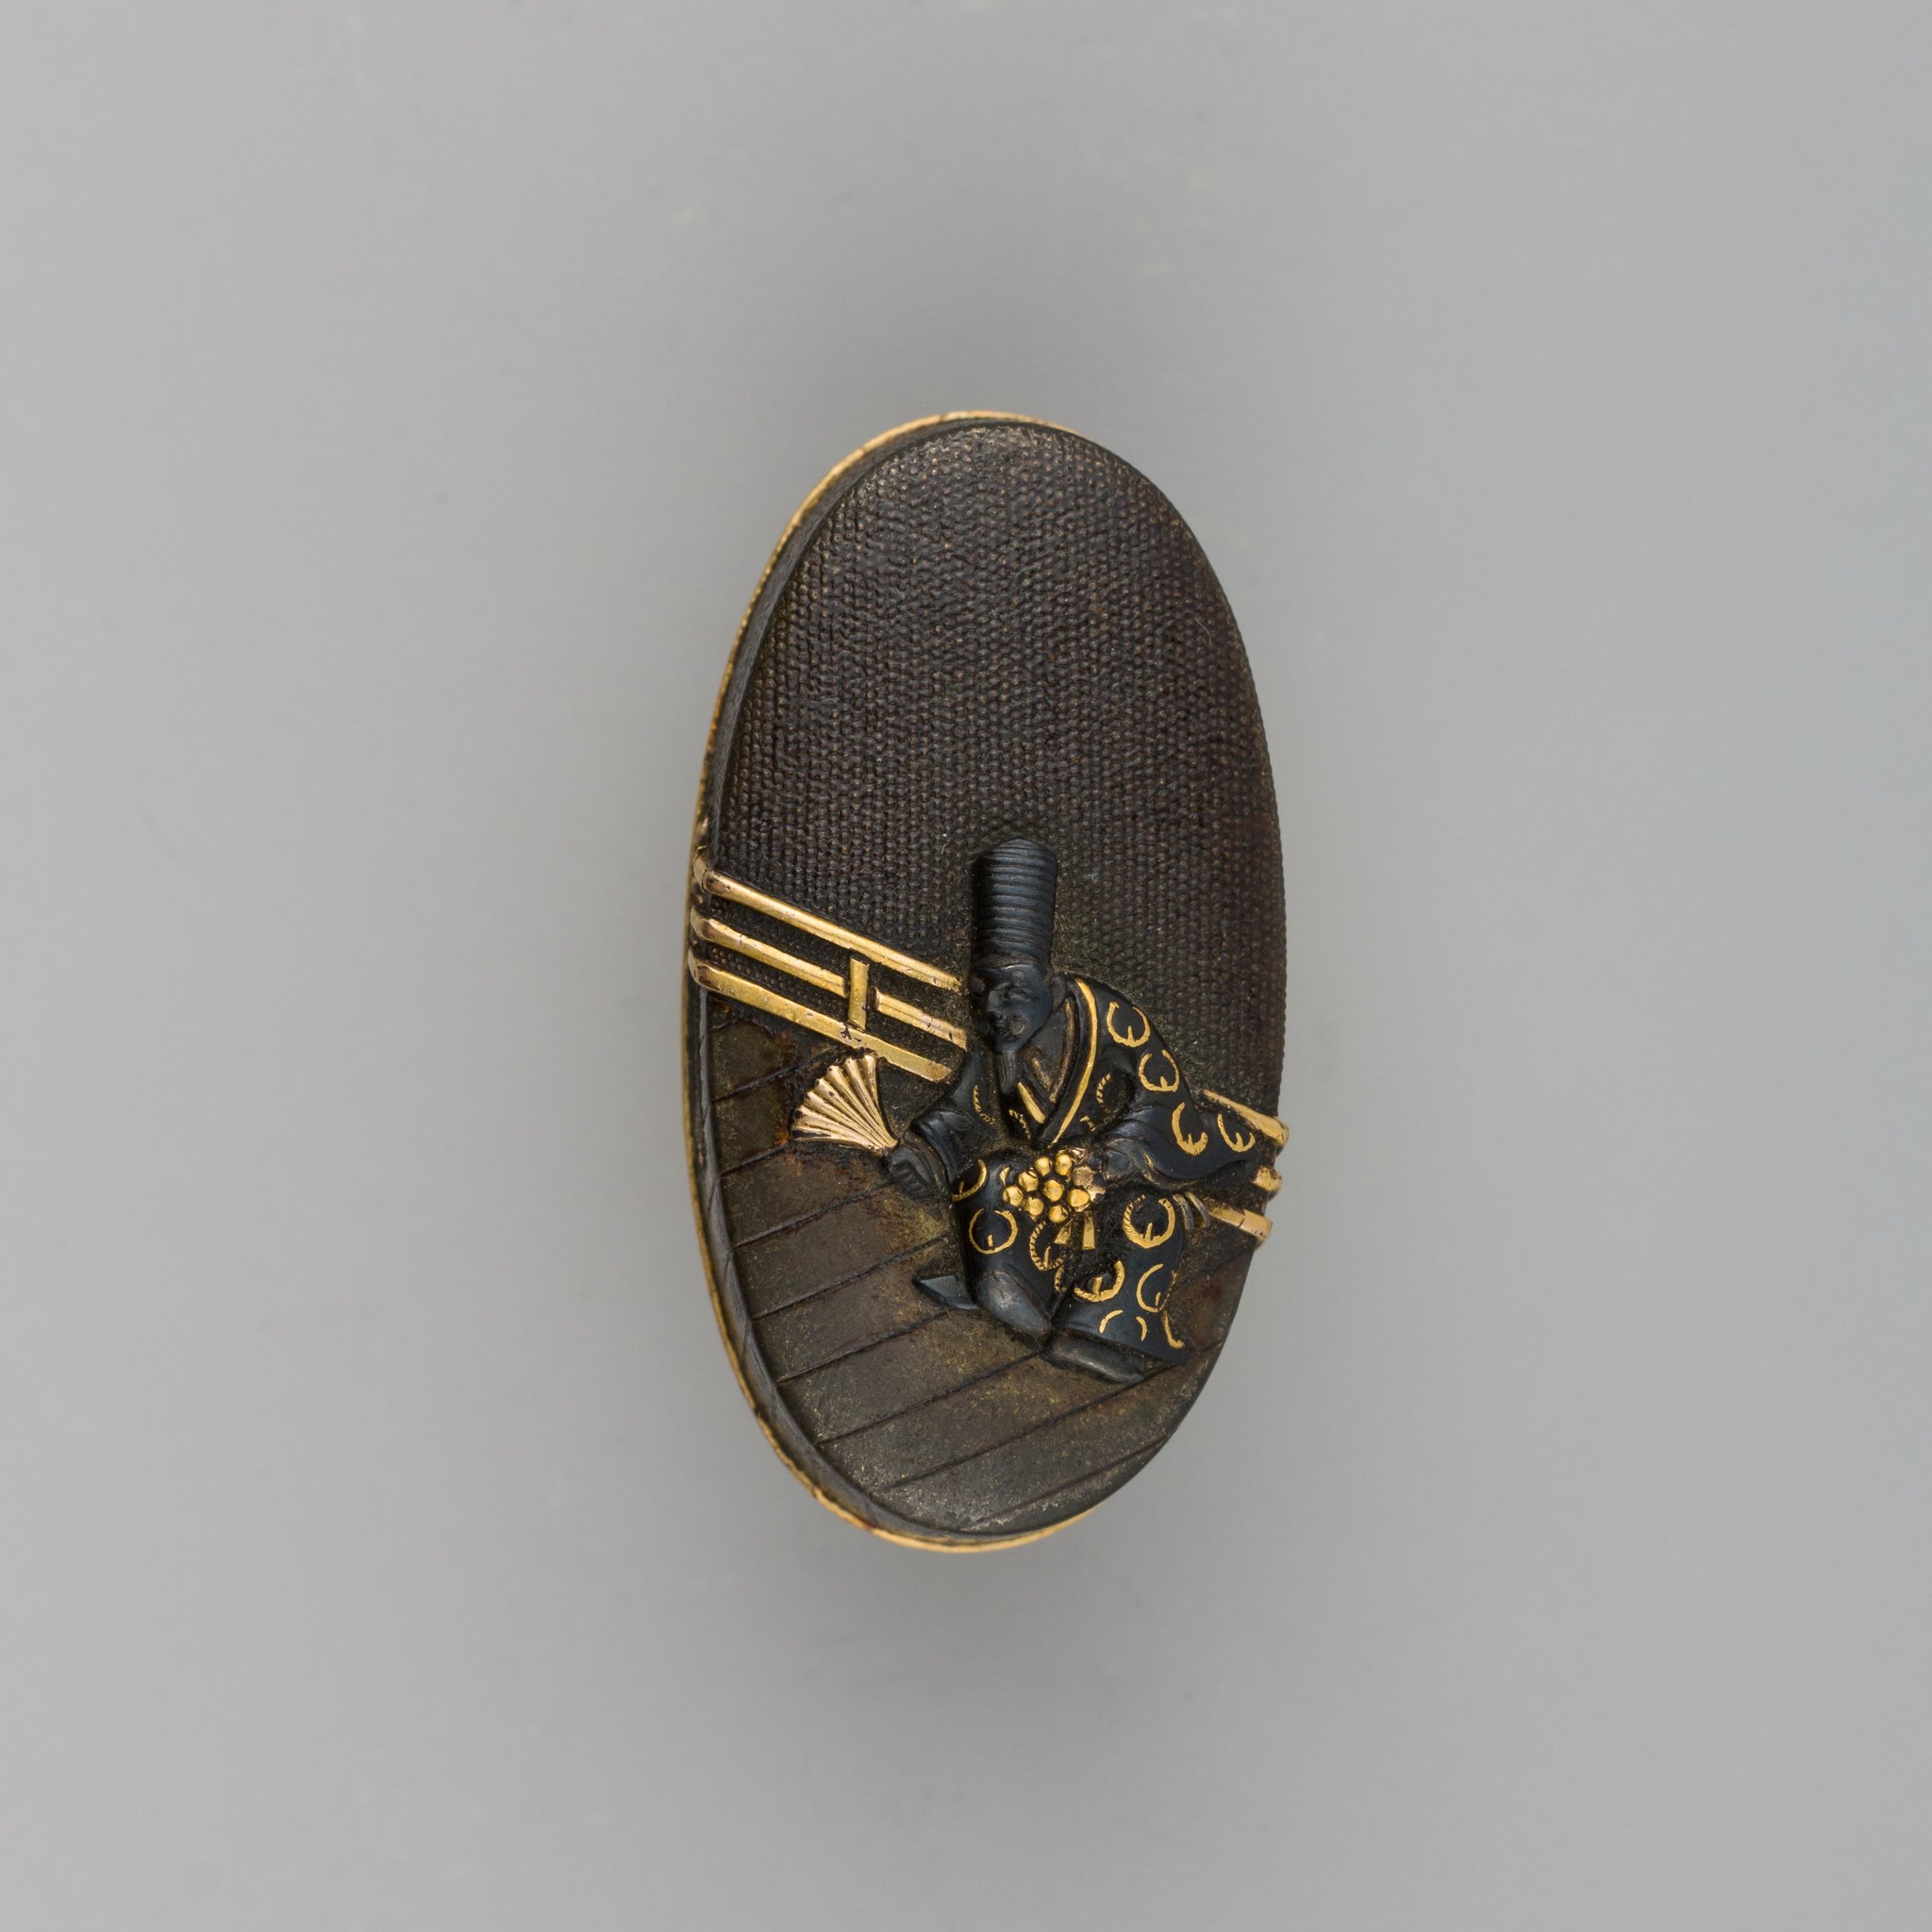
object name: sword pommel kashira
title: Sword Pommel (Kashira)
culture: japanese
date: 1615-1868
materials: gold alloy, silver alloy, gold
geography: japan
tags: men